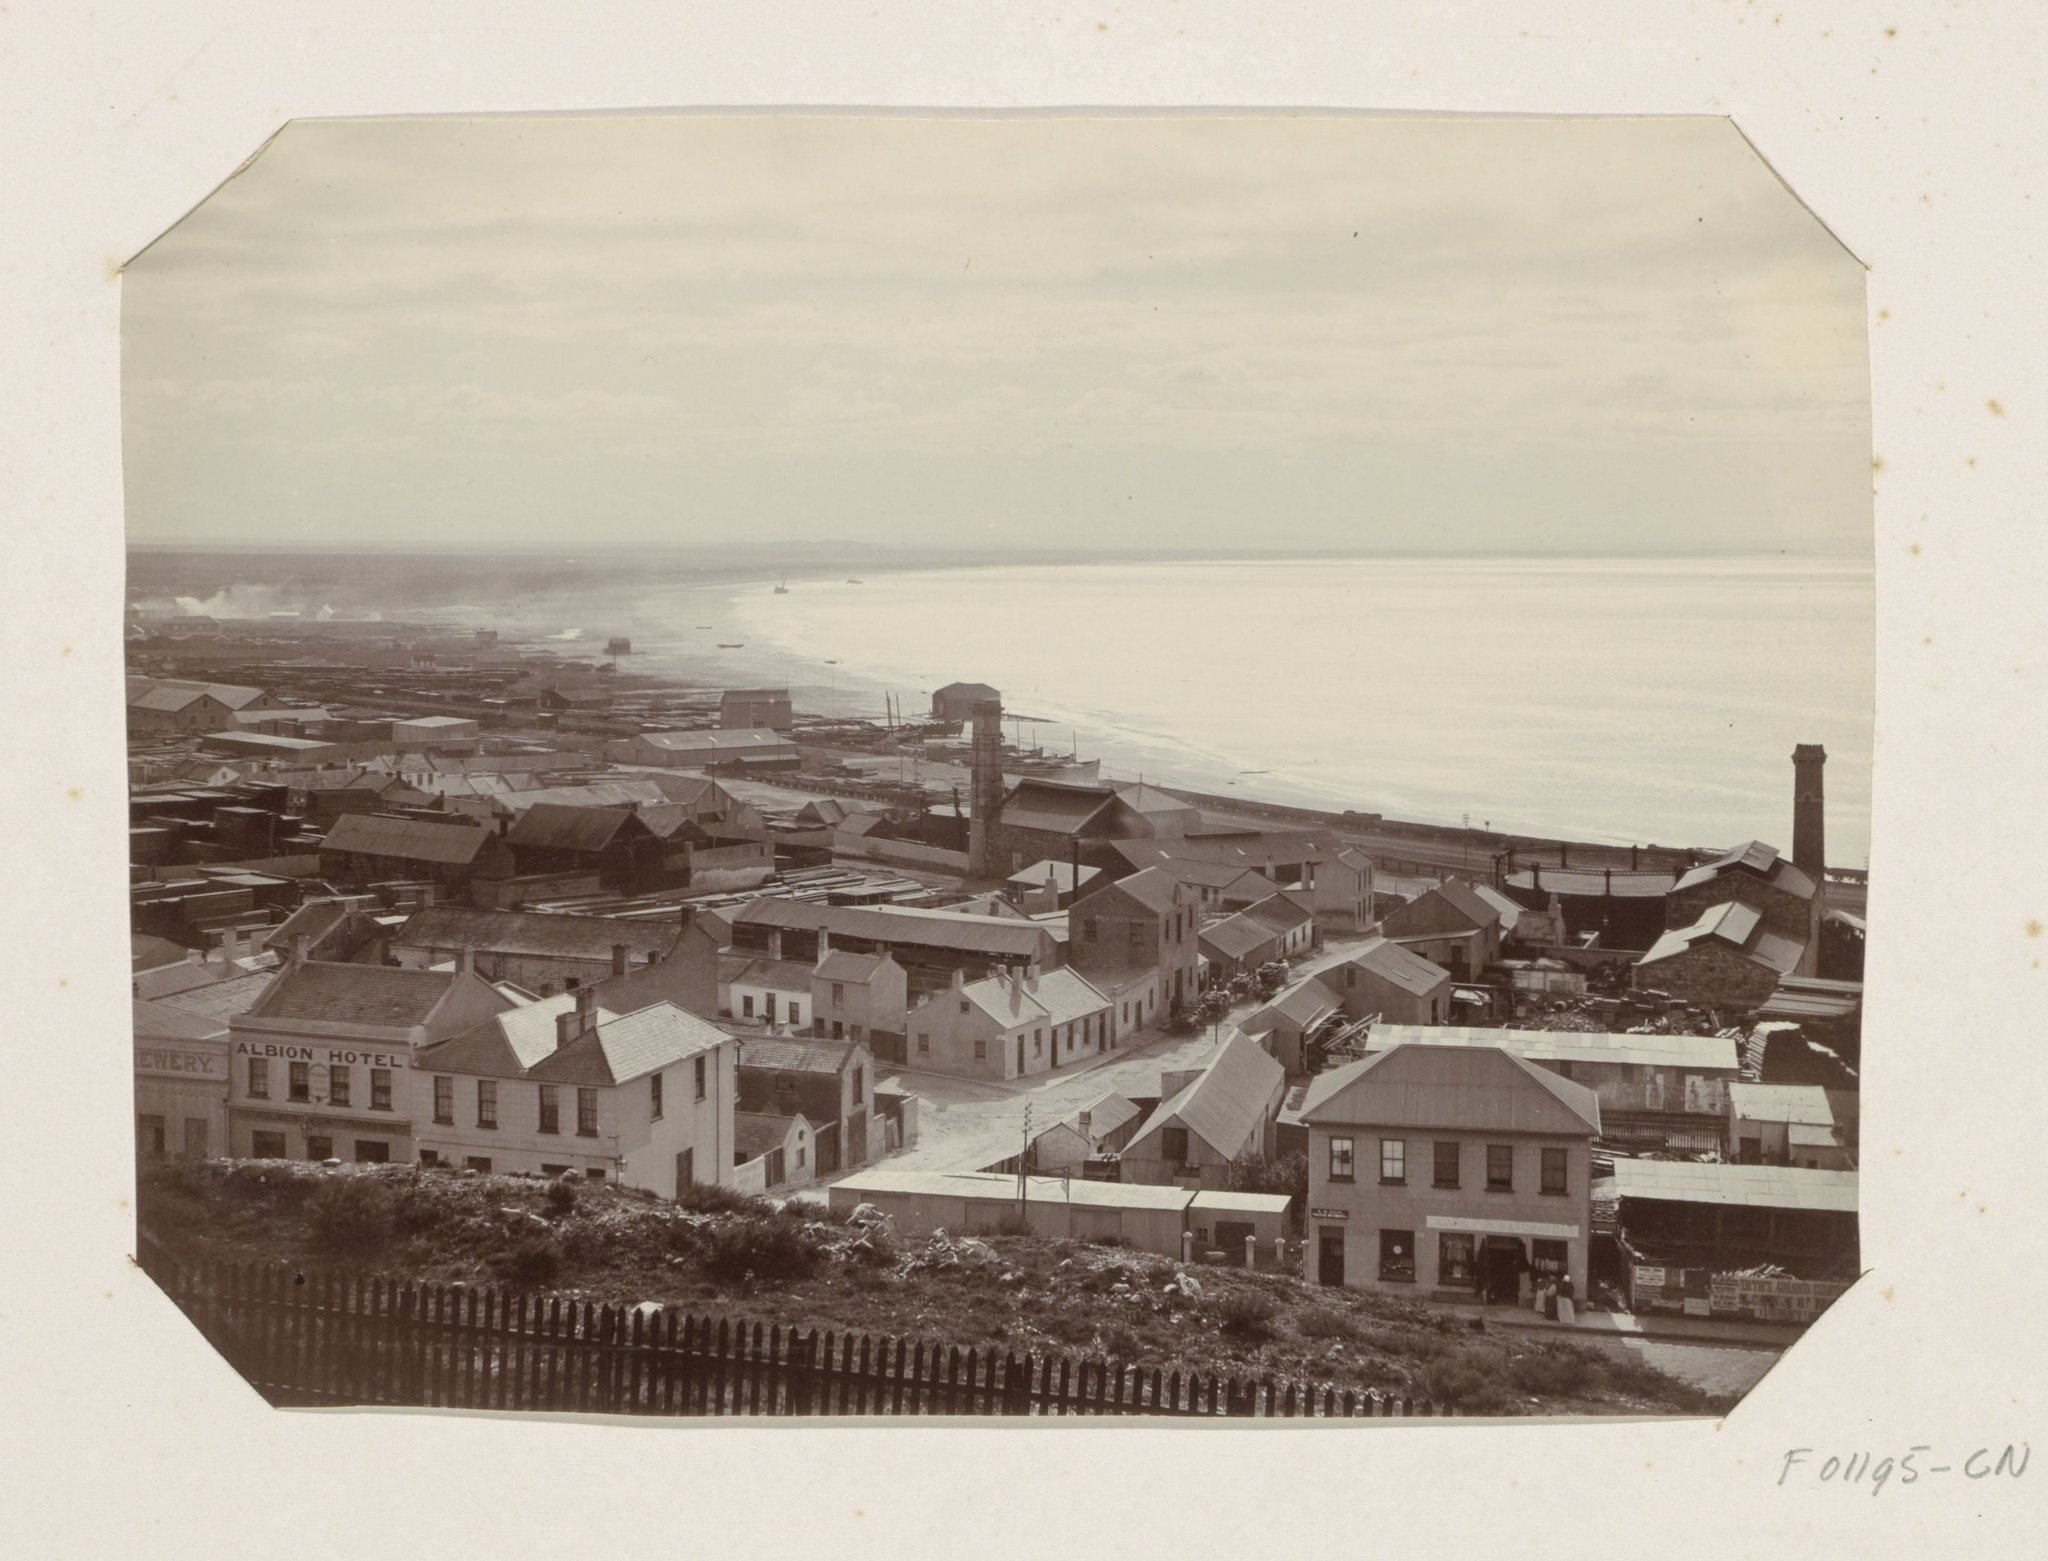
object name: photograph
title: Stad met industrie aan zee, vermoedelijk in Zuid-Afrika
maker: Anonymous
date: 1880-1910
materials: cardboard, paper, photographic support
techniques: gelatin silver print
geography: south africa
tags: prospect of city, town panorama, silhouette of city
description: Onderdeel van Fotoalbum van een reis door de Verenigde Staten, Honolulu, Nederlands-Indië, Aden, Zanzibar en Zuidelijk Afrika.